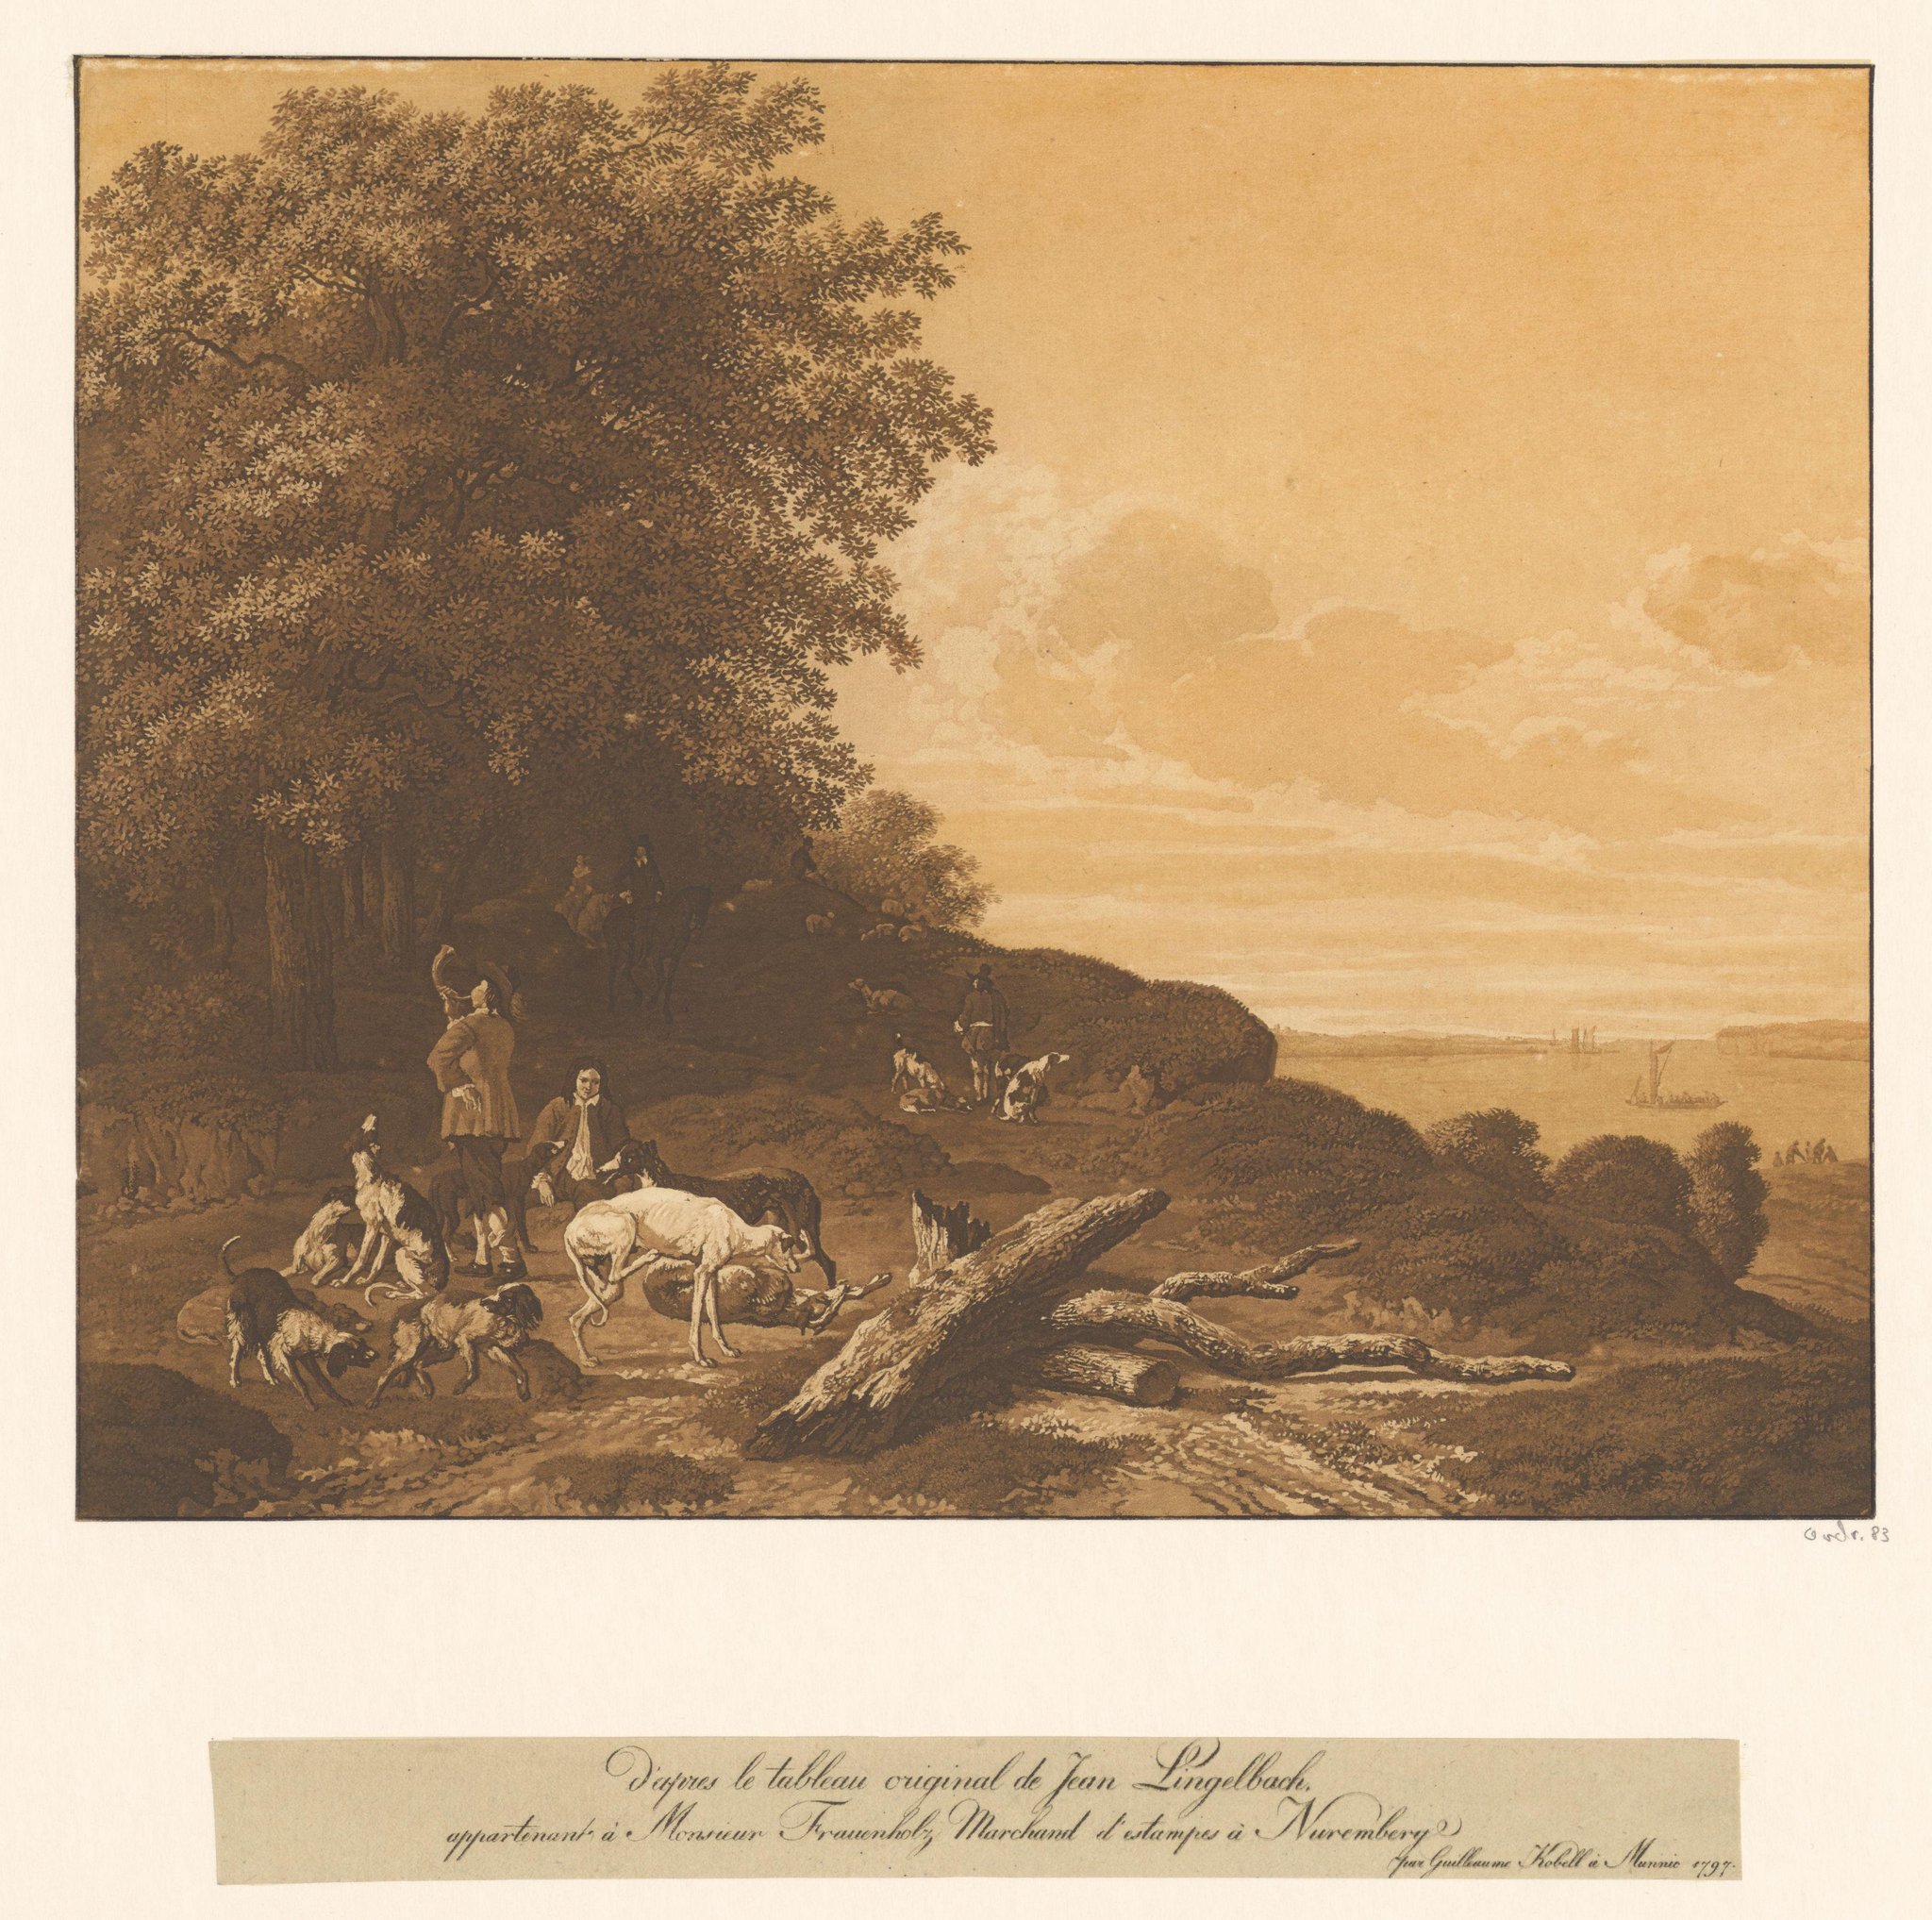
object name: print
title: Landschap met jagers aan de bosrand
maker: wilhelm alexander wolfgang von kobell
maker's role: print maker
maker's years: 1766-1855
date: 1797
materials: paper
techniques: aquatint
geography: munich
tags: hunting dogs, hunters resting during the hunt, forest path or lane, coast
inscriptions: collector's mark: Lugt 1020, collector's mark: Lugt 2228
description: Een losse strook met tekst in het Frans is onder prent op het opzetvel geplakt. Hierop staat dat de prent gemaakt is naar een schilderij door Johannes Lingelbach uit de collectie van Johann Friedrich Frauenholz (1758-1822) kunstverkoper in Neurenberg.